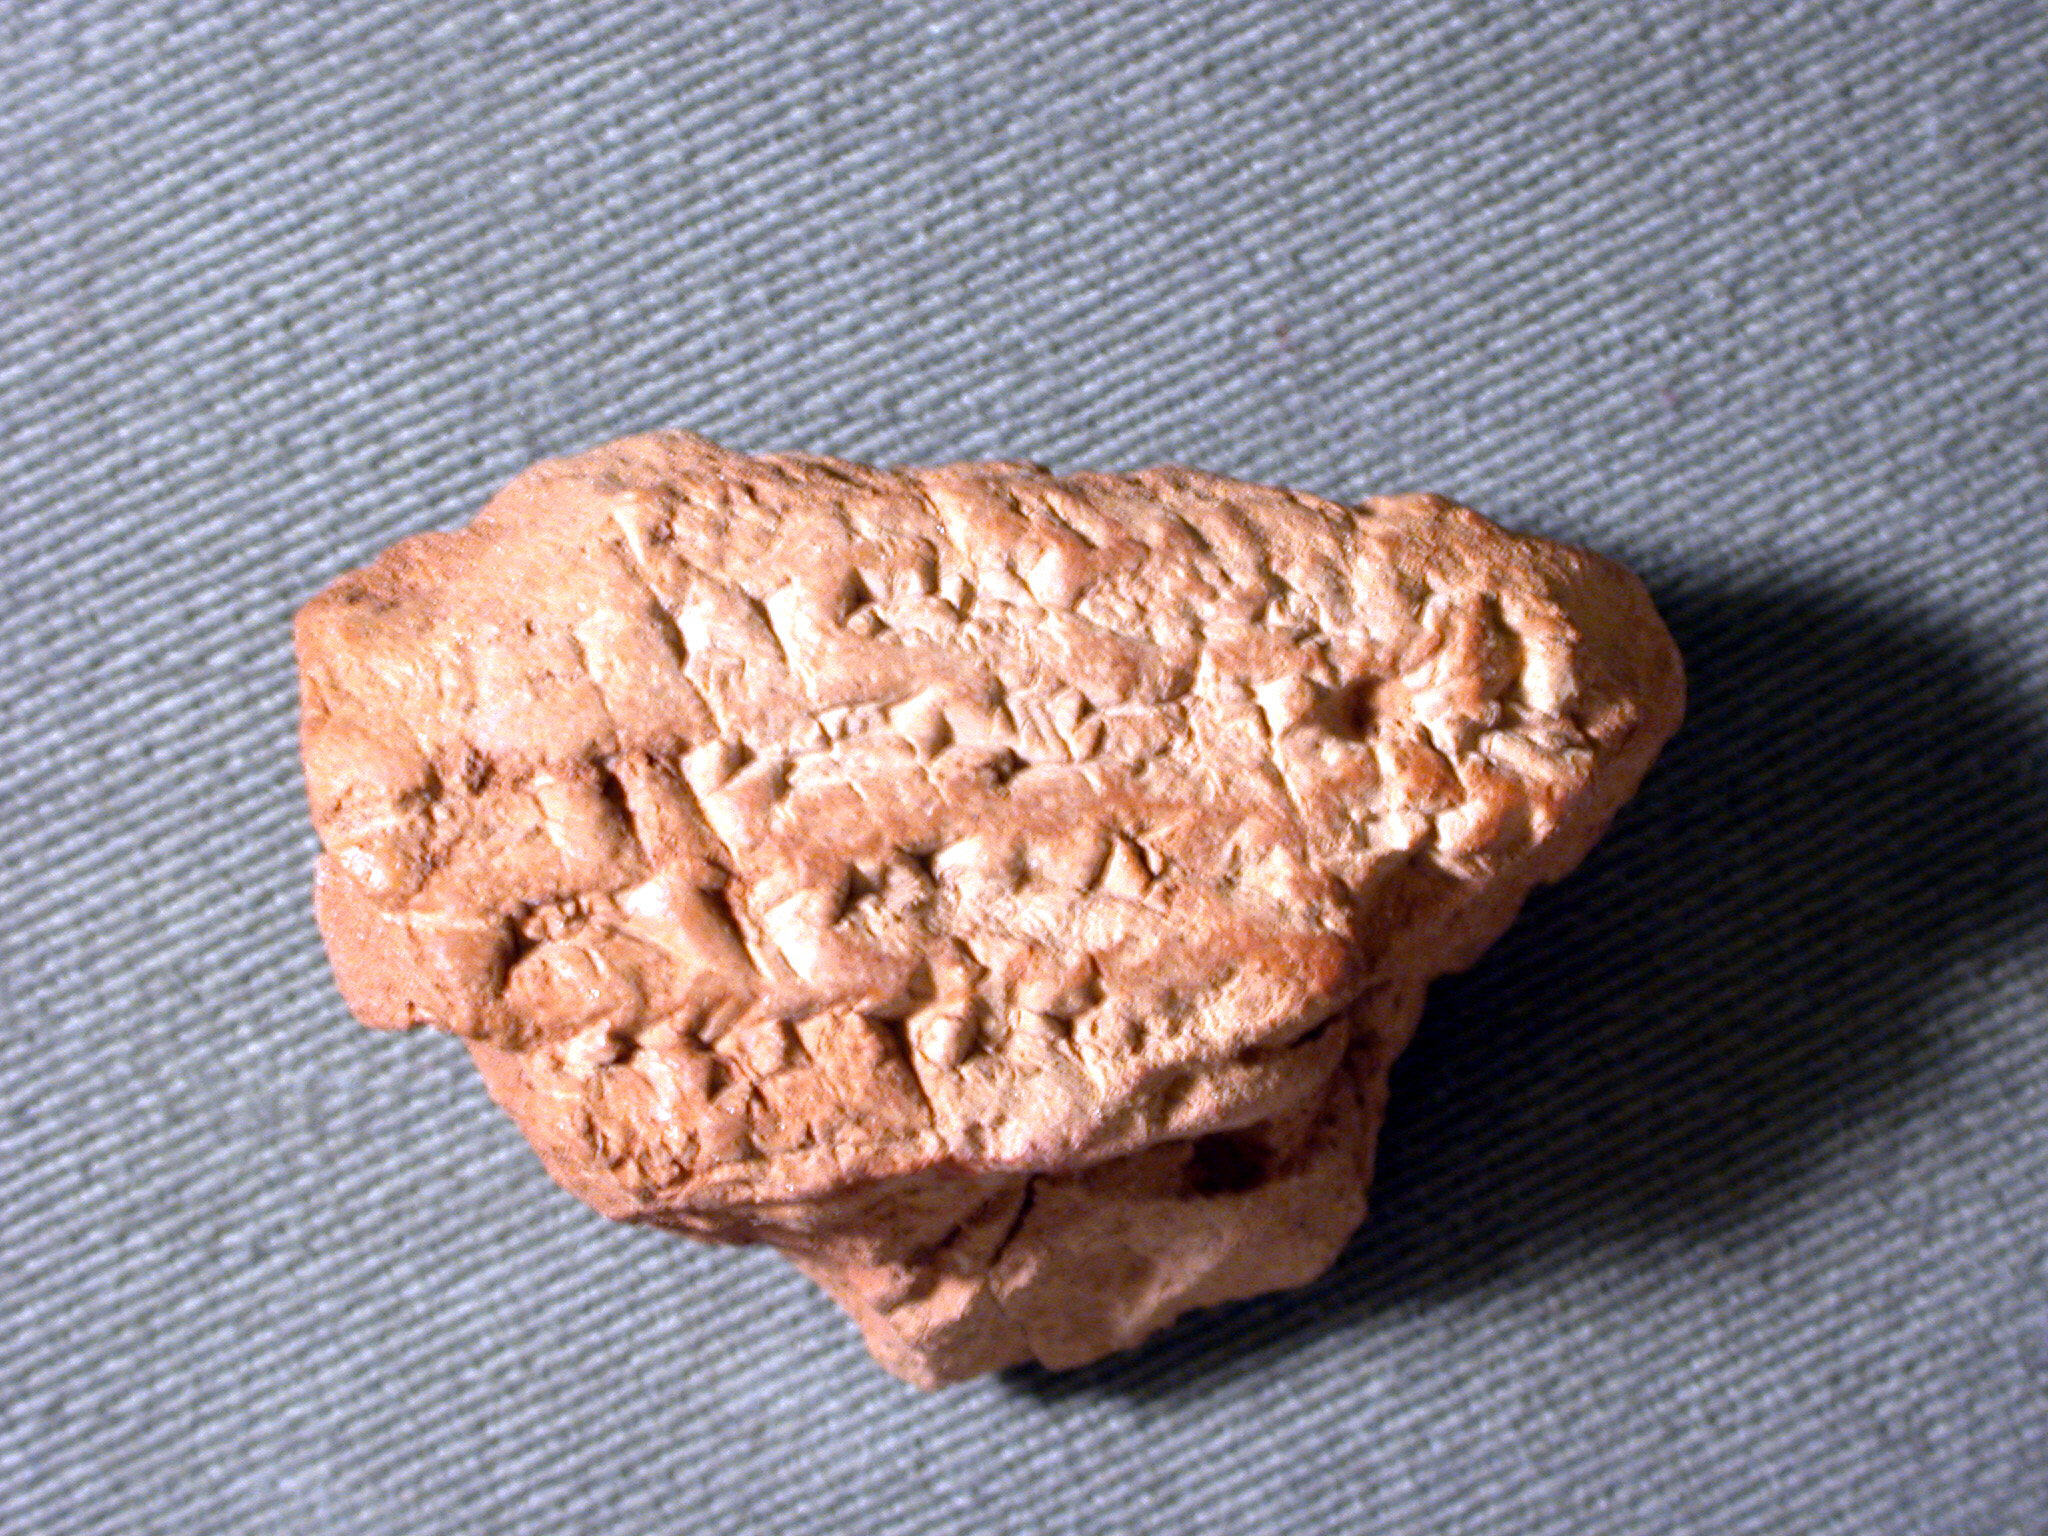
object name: cuneiform tablet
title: Cuneiform tablet: fragment, Ebabbar archive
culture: achaemenid or babylonian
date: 700-301 BCE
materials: clay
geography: mesopotamia